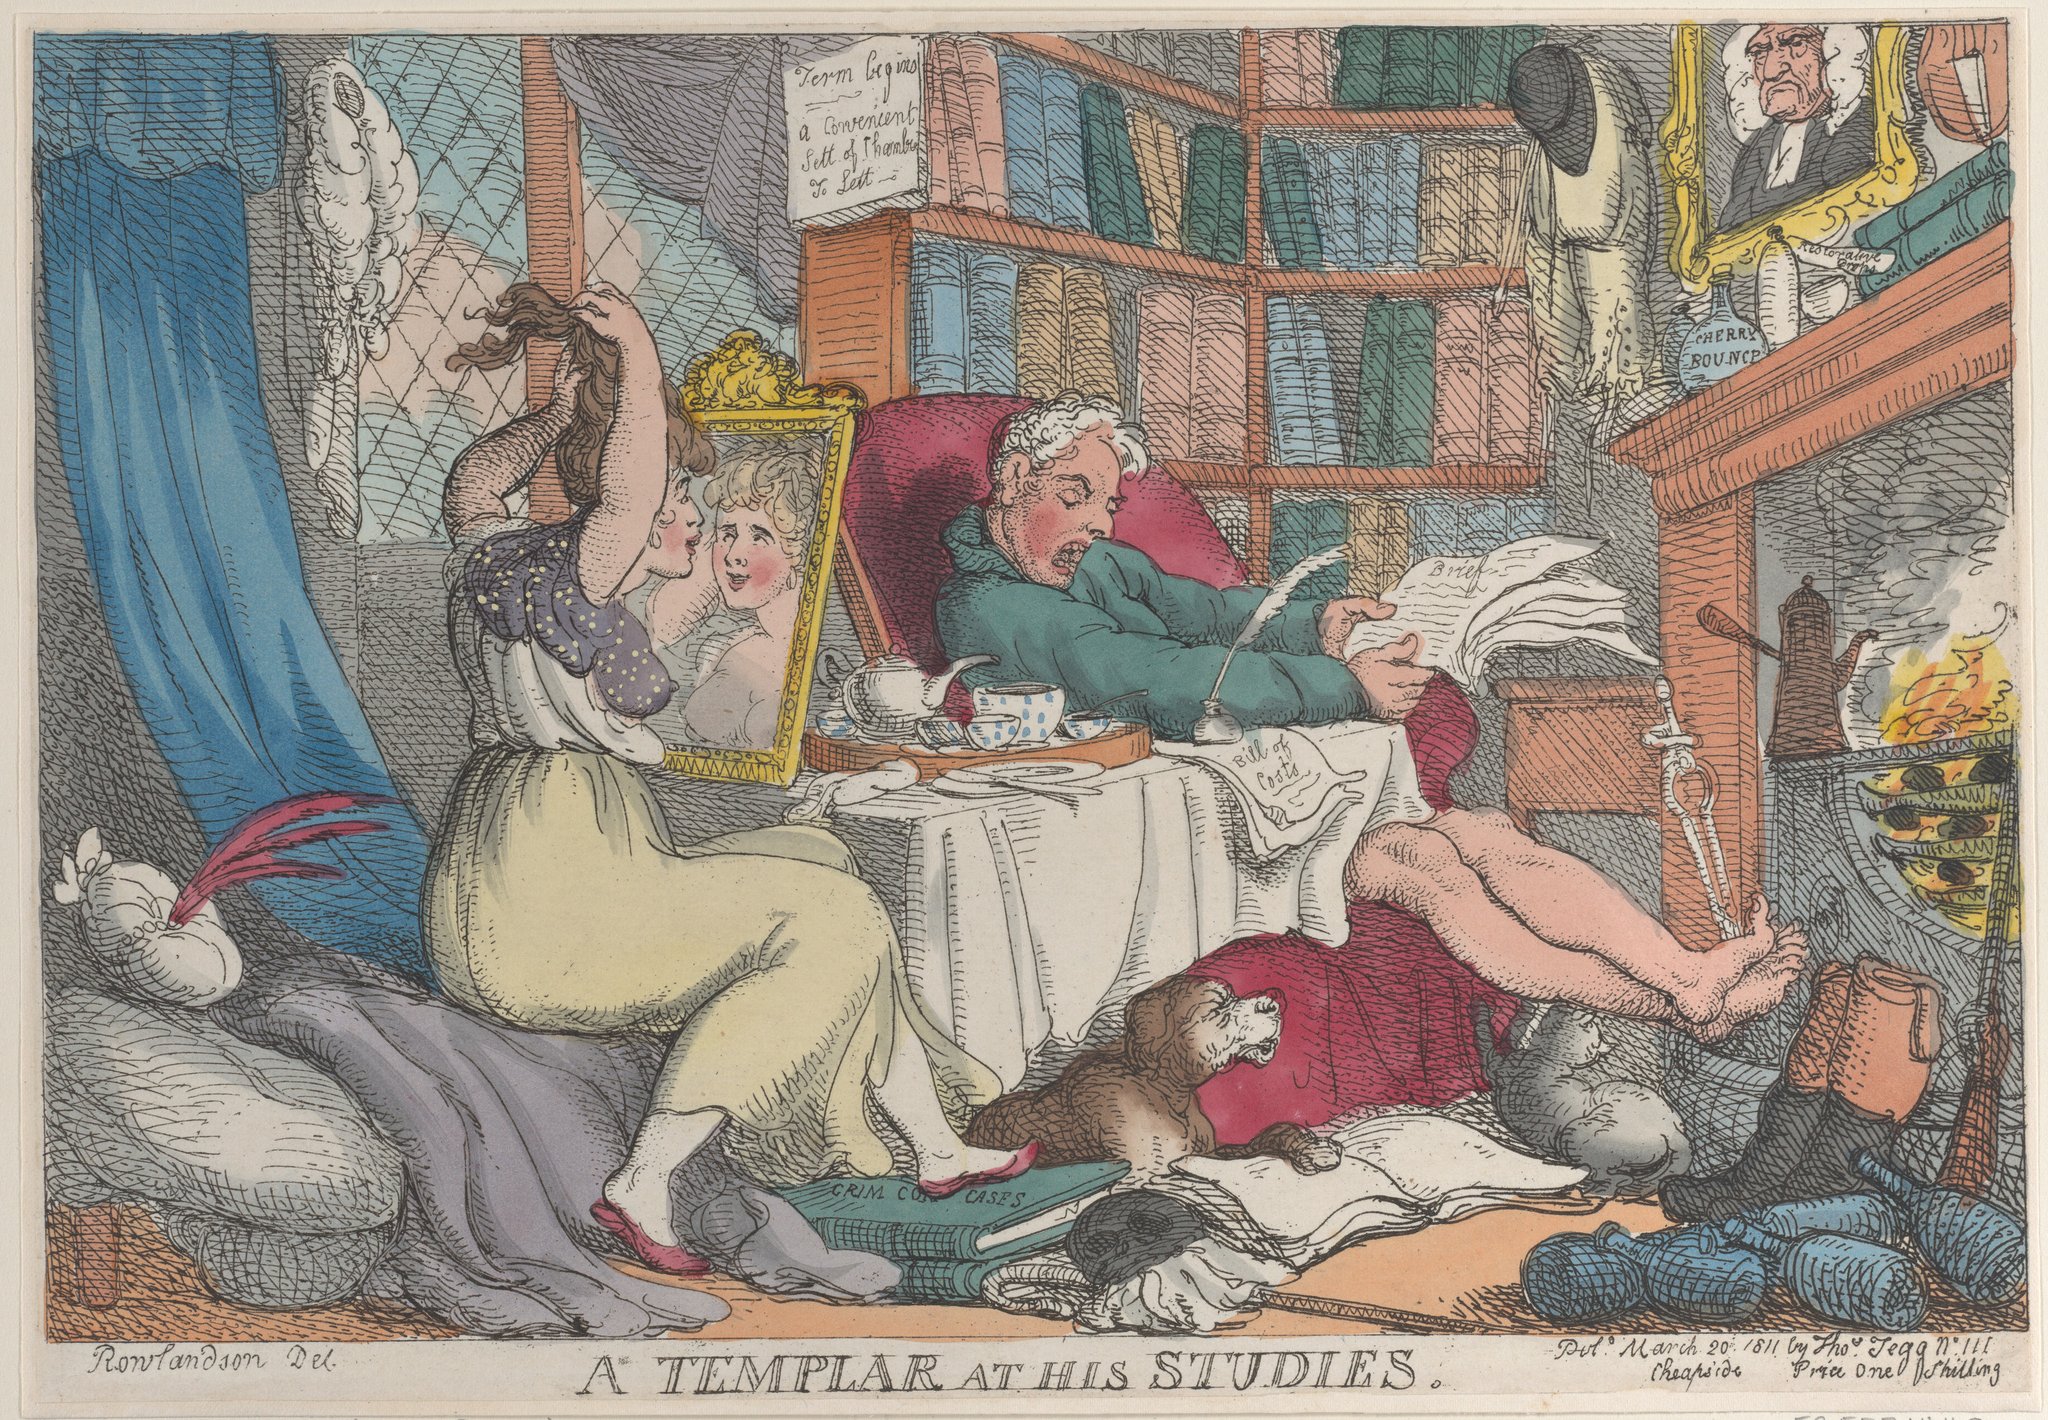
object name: print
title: A Templar at His Studies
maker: thomas rowlandson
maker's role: artist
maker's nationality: british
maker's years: 1757-1827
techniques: etching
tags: satire,men,women,dogs